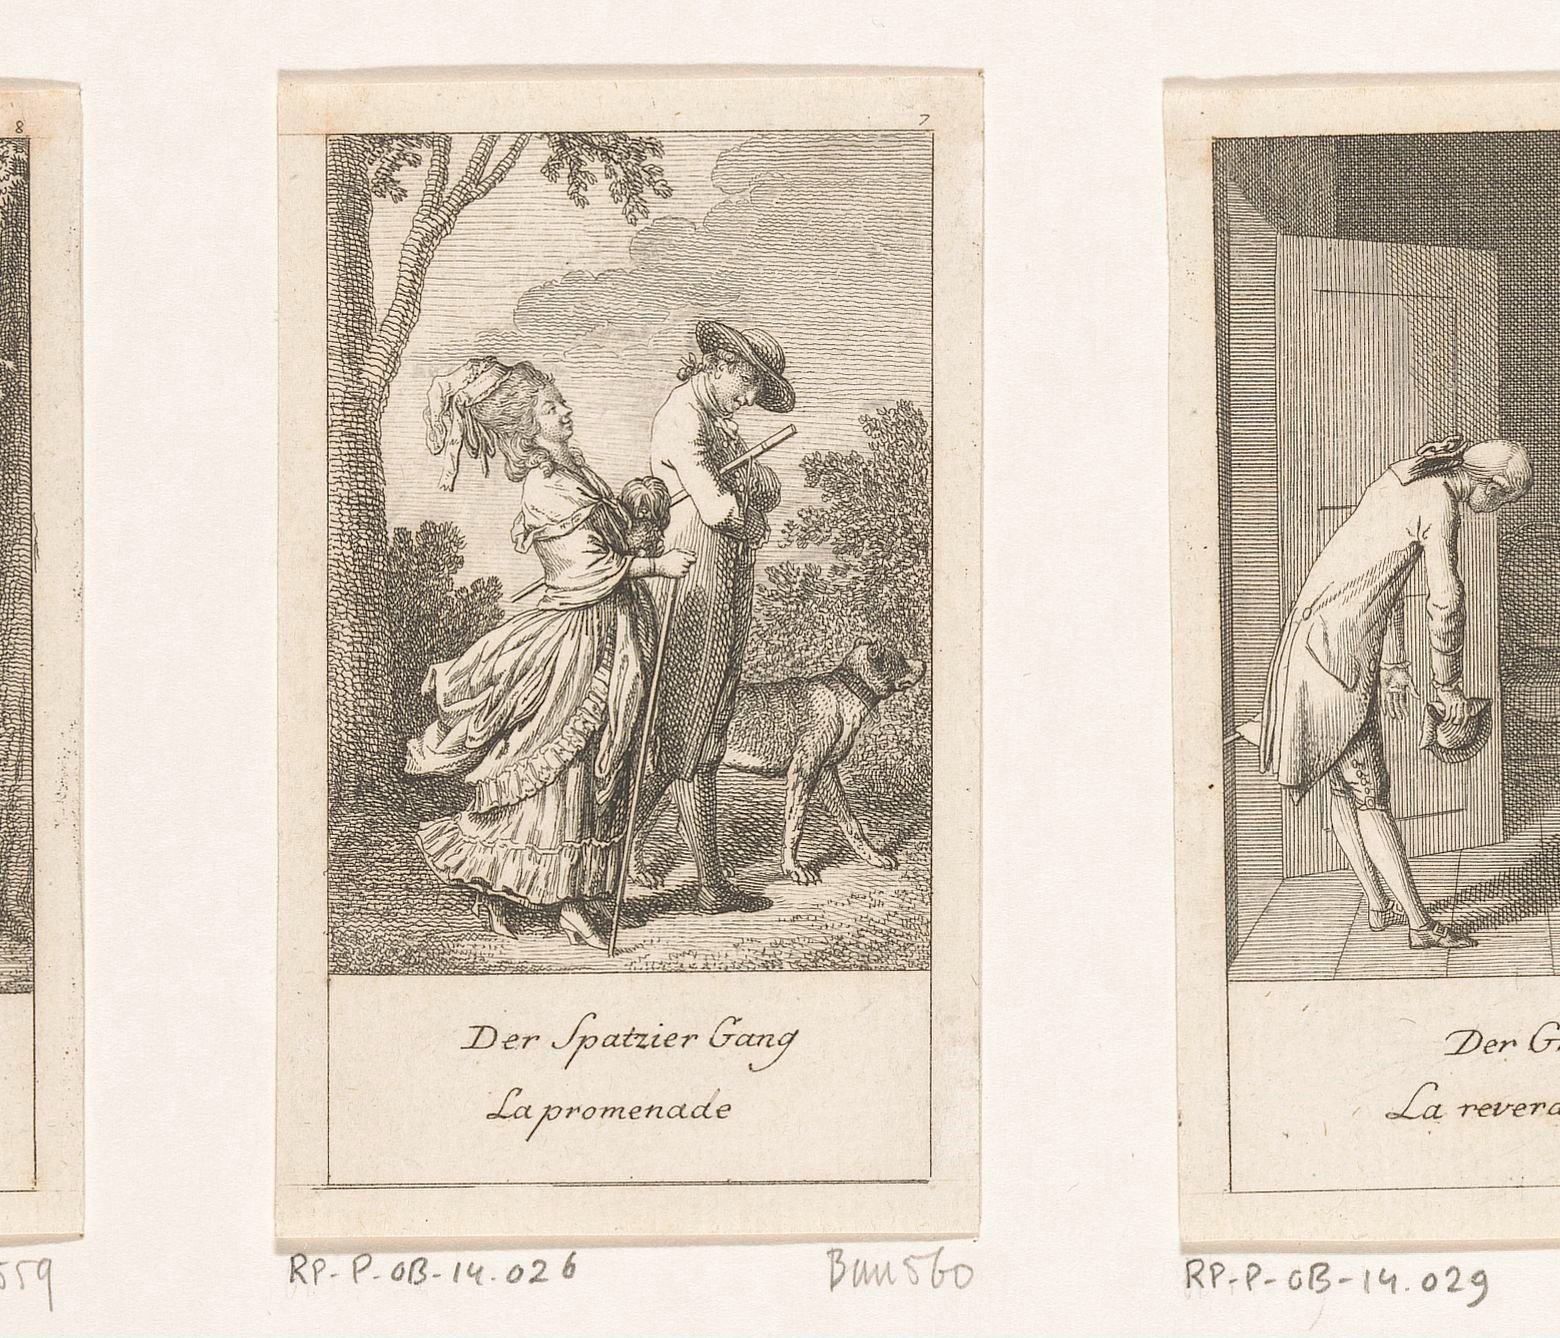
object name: print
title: Der Spatzier Gang / La promenade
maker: daniel nikolaus chodowiecki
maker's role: draughtsman, print maker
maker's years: 1726-1801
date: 1778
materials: paper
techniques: etching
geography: berlin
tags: physicist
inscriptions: collector's mark: Lugt 2228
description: Zevende prent uit een serie van twaalf taferelen die 'Natürliche und affectirte Handlungen des Lebens' (eerste serie) illustreren waarin 'natuurlijk' en 'geaffecteerd' gedrag op karikaturale wijze tegenover elkaar worden gezet. Deze taferelen zijn op een plaat geëtst. Deze serie, voorzien van toelichtingen door Georg Christoph Lichtenberg, is ook gebruikt in: Goettinger Taschen Calender vom Jahre 1779. Göttingen: Johann Christian Dieterich.